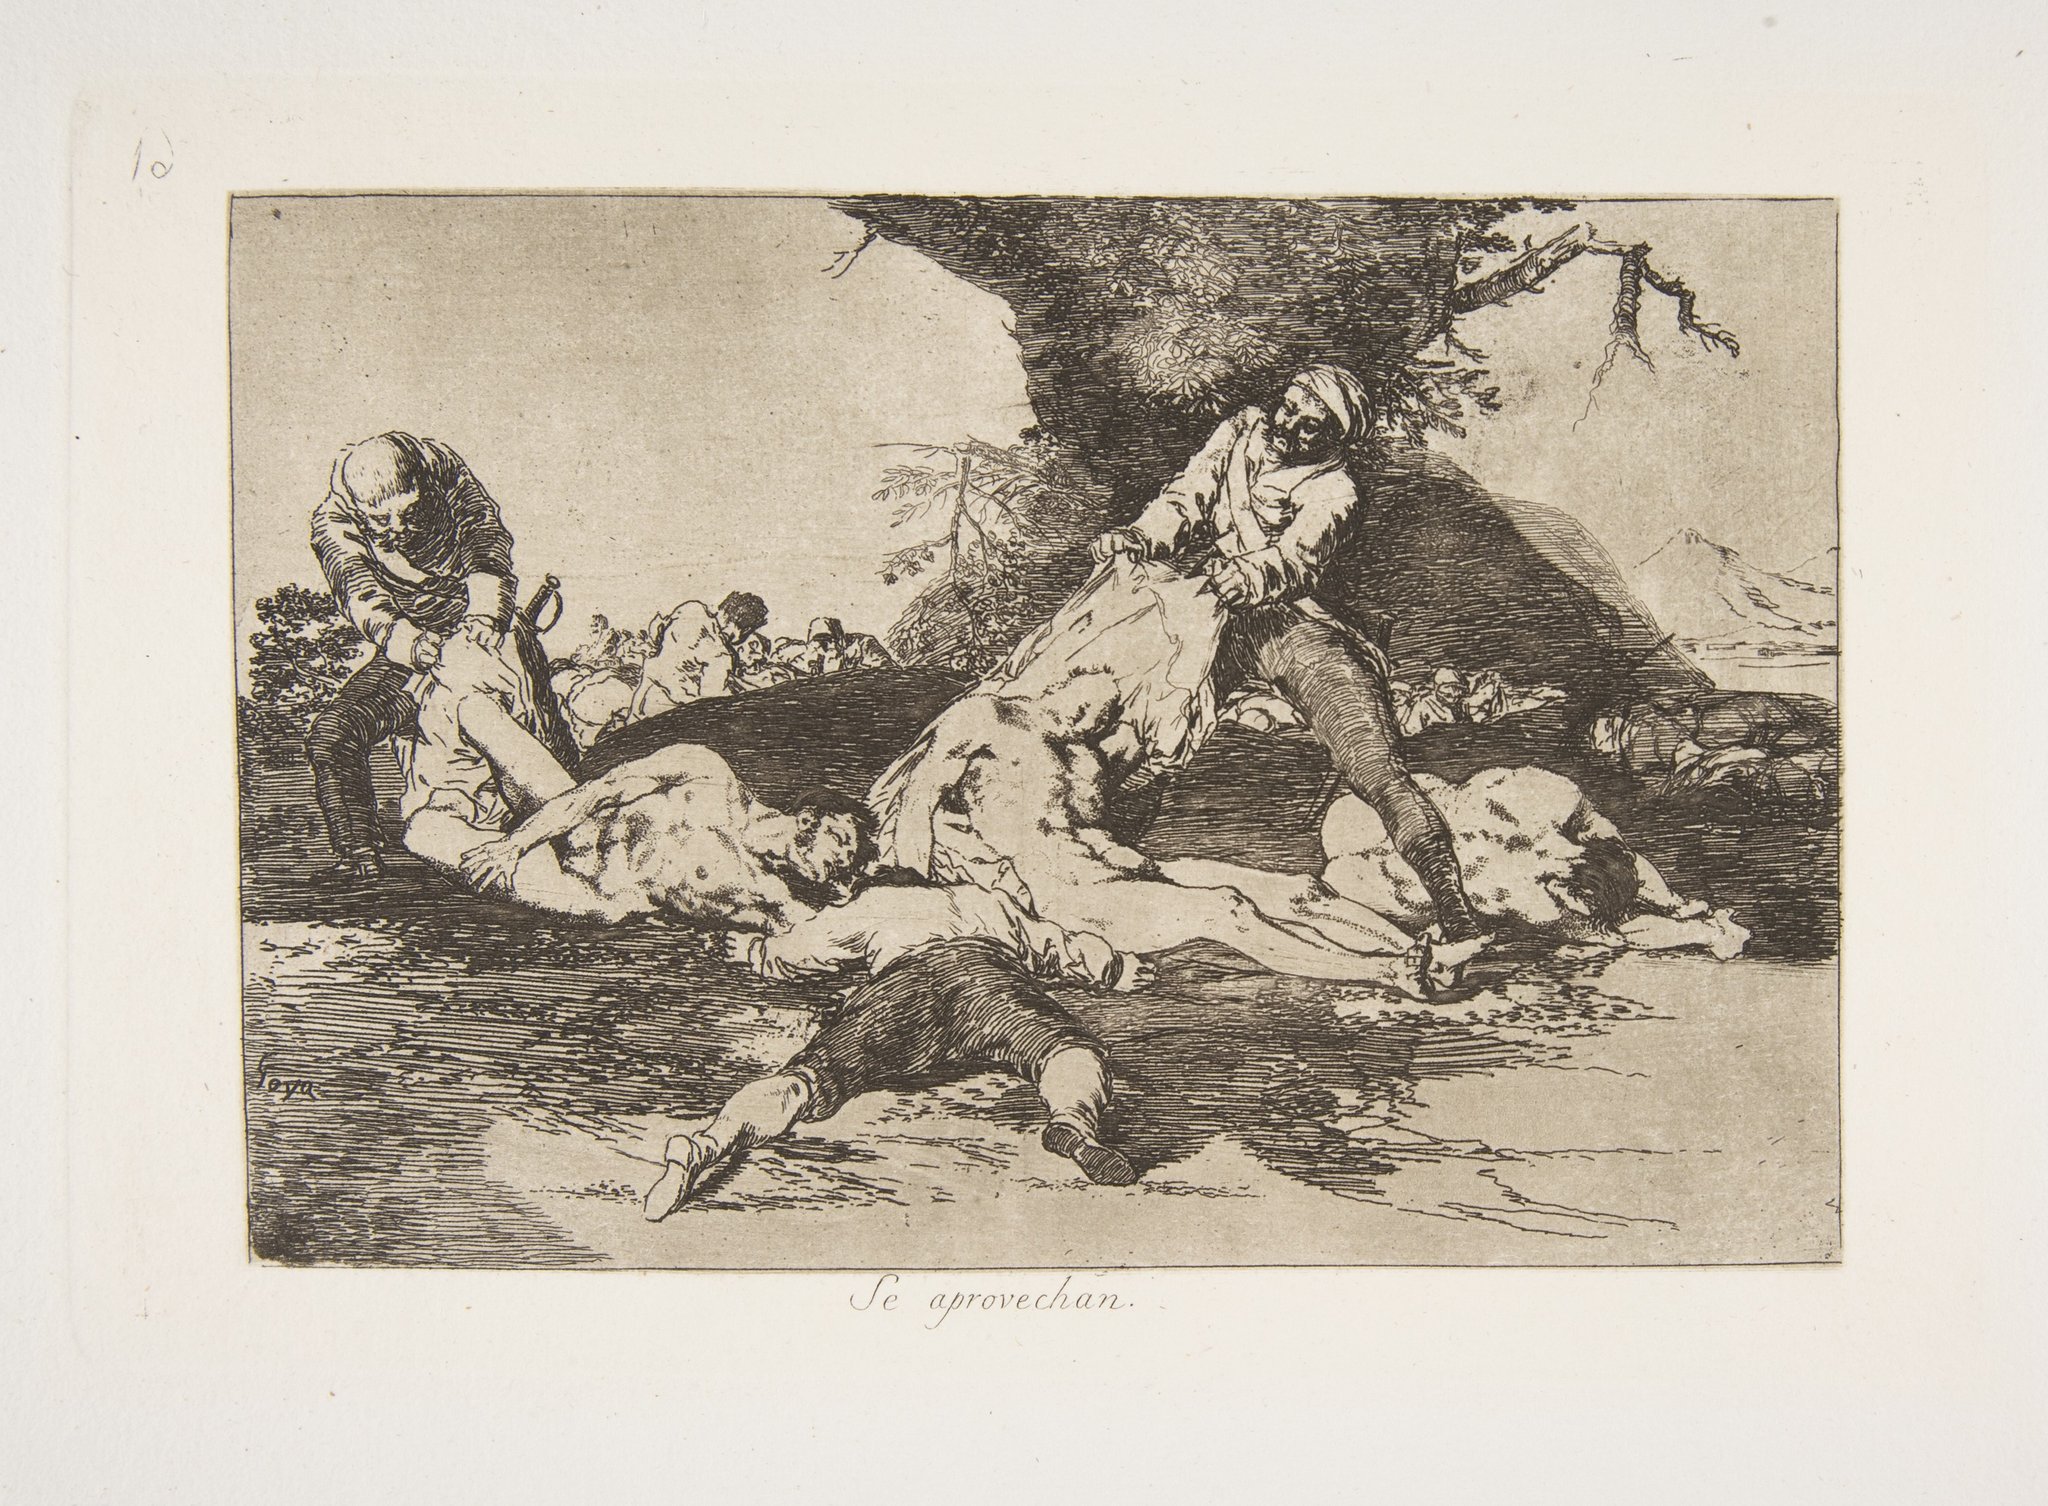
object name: print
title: Plate 16 from "The Disasters of War" (Los Desastres de la Guerra): 'They make use of them' (Se aprovechan)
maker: goya (francisco de goya y lucientes)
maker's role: artist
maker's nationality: spanish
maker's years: 1746-1828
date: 1810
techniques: engraving, drypoint, etching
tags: corpses,men,death